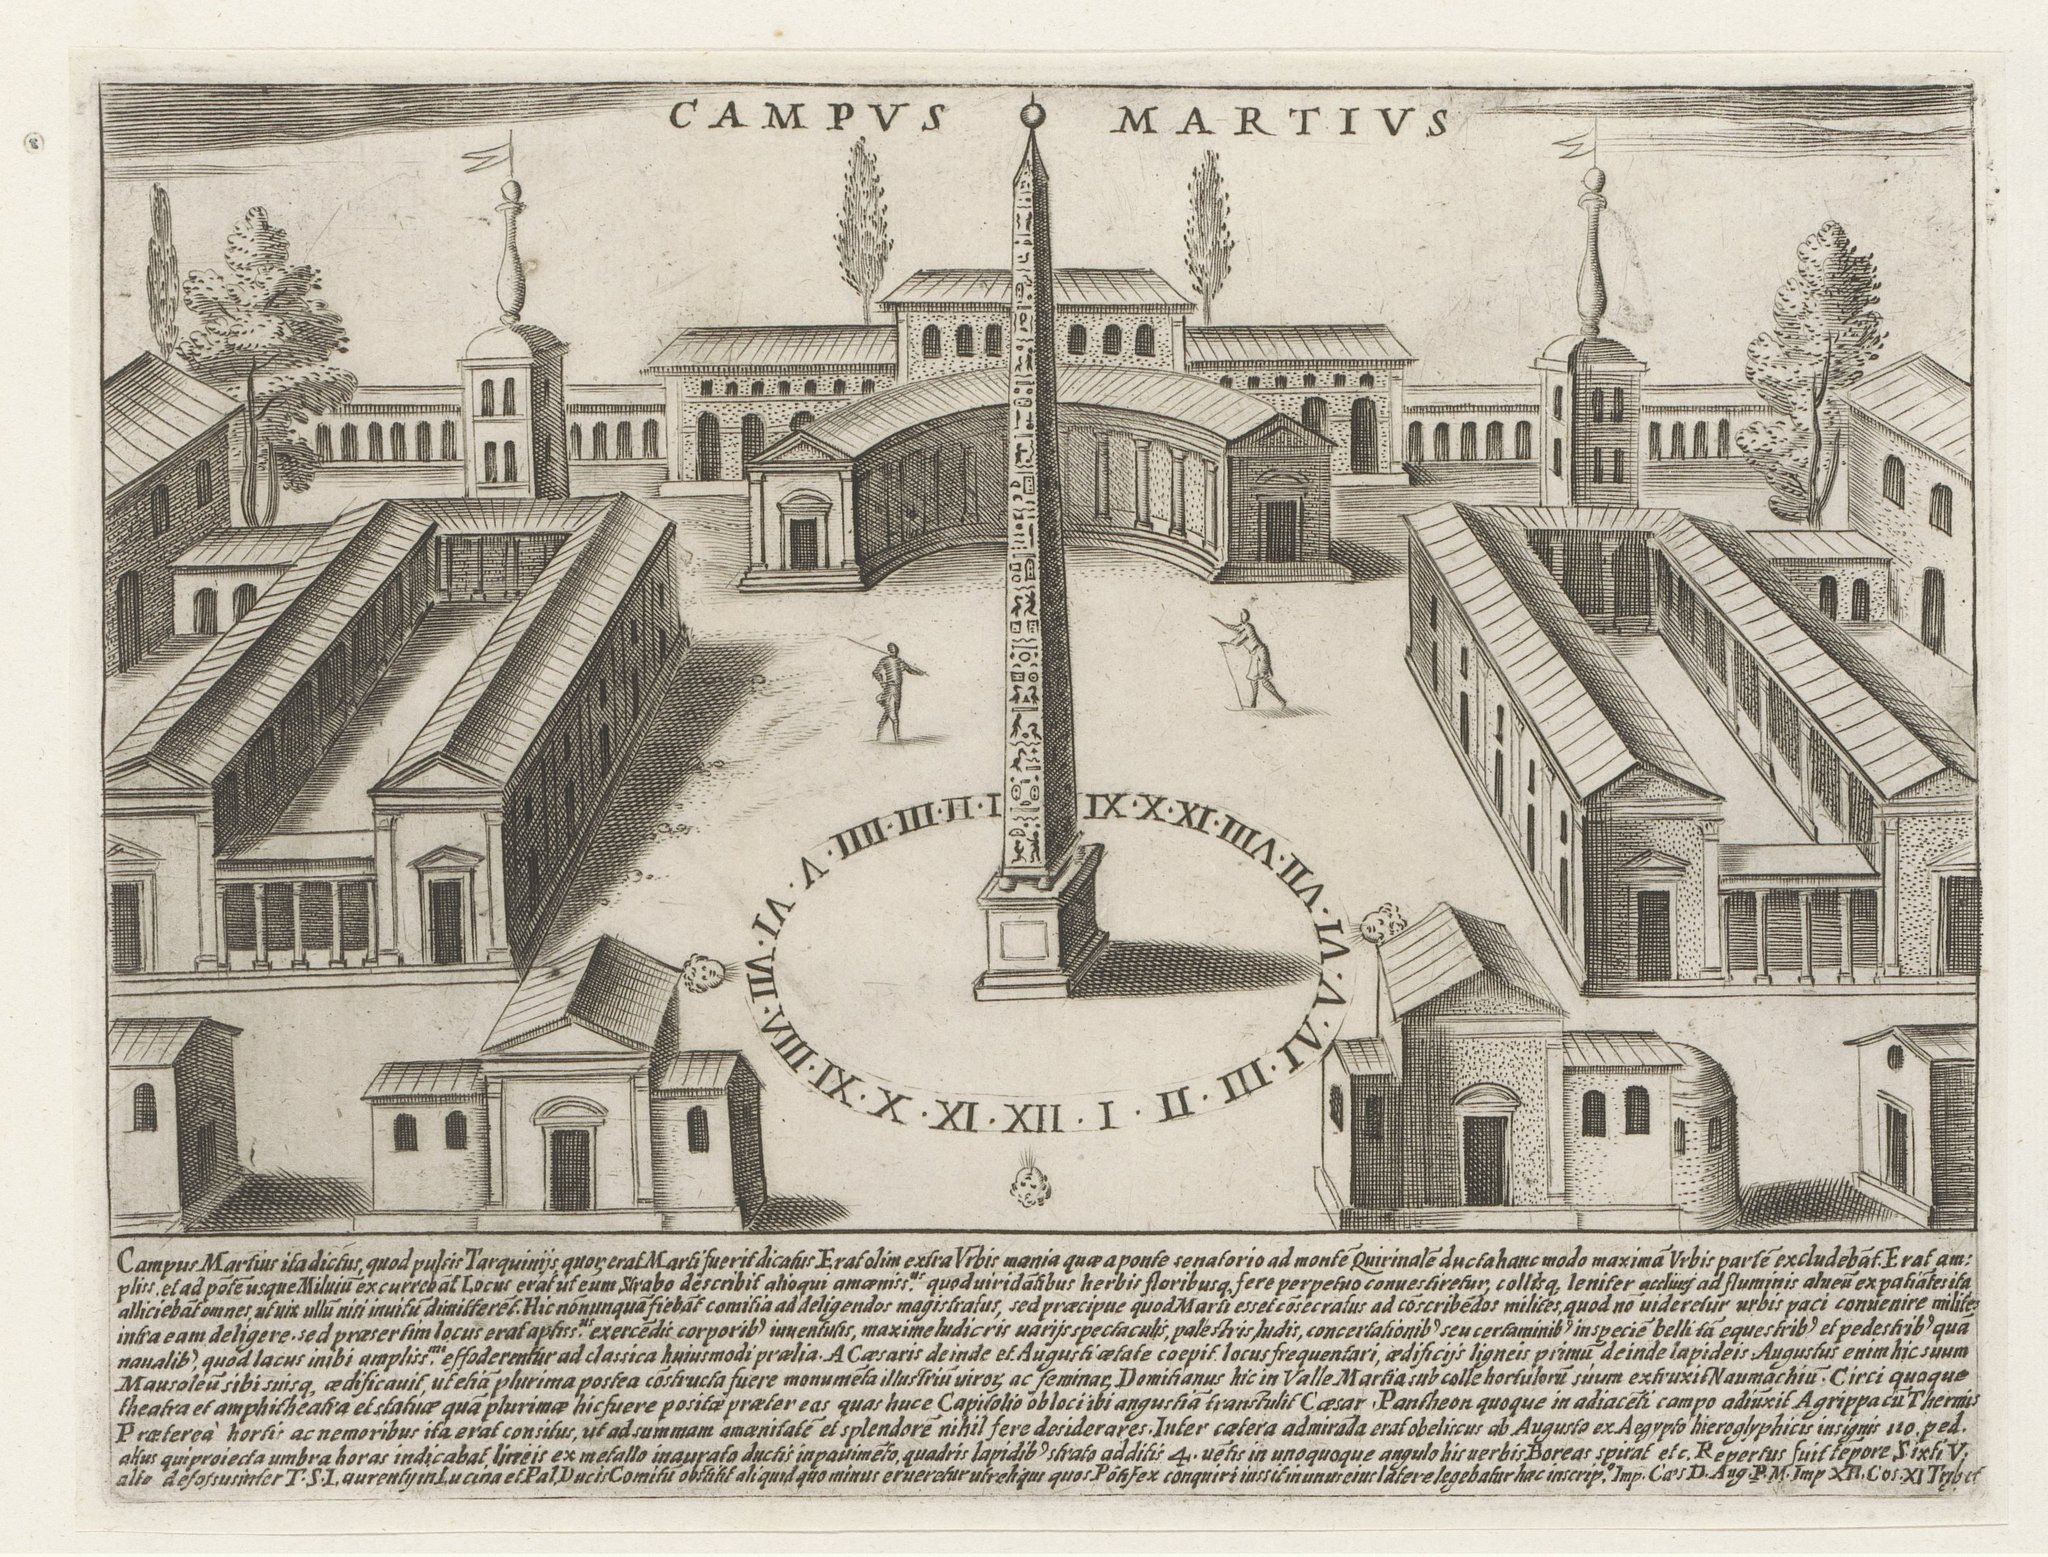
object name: album leaf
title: Magesyn der Italiaense gebouwen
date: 1612-1628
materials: paper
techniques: etching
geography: rome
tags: square, place, circus, etc., obelisk, needle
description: Deze prent maakt deel uit van een set van 158 prenten (+ titelprenten), die verscheen in vier delen. In 1612 verschenen delen één en twee. In 1615 verscheen het derde deel en in 1628 verscheen deel vier. In 1637 publiceerde Vitale Mascardi de eerste heruitgave van de gehele set met nummering.